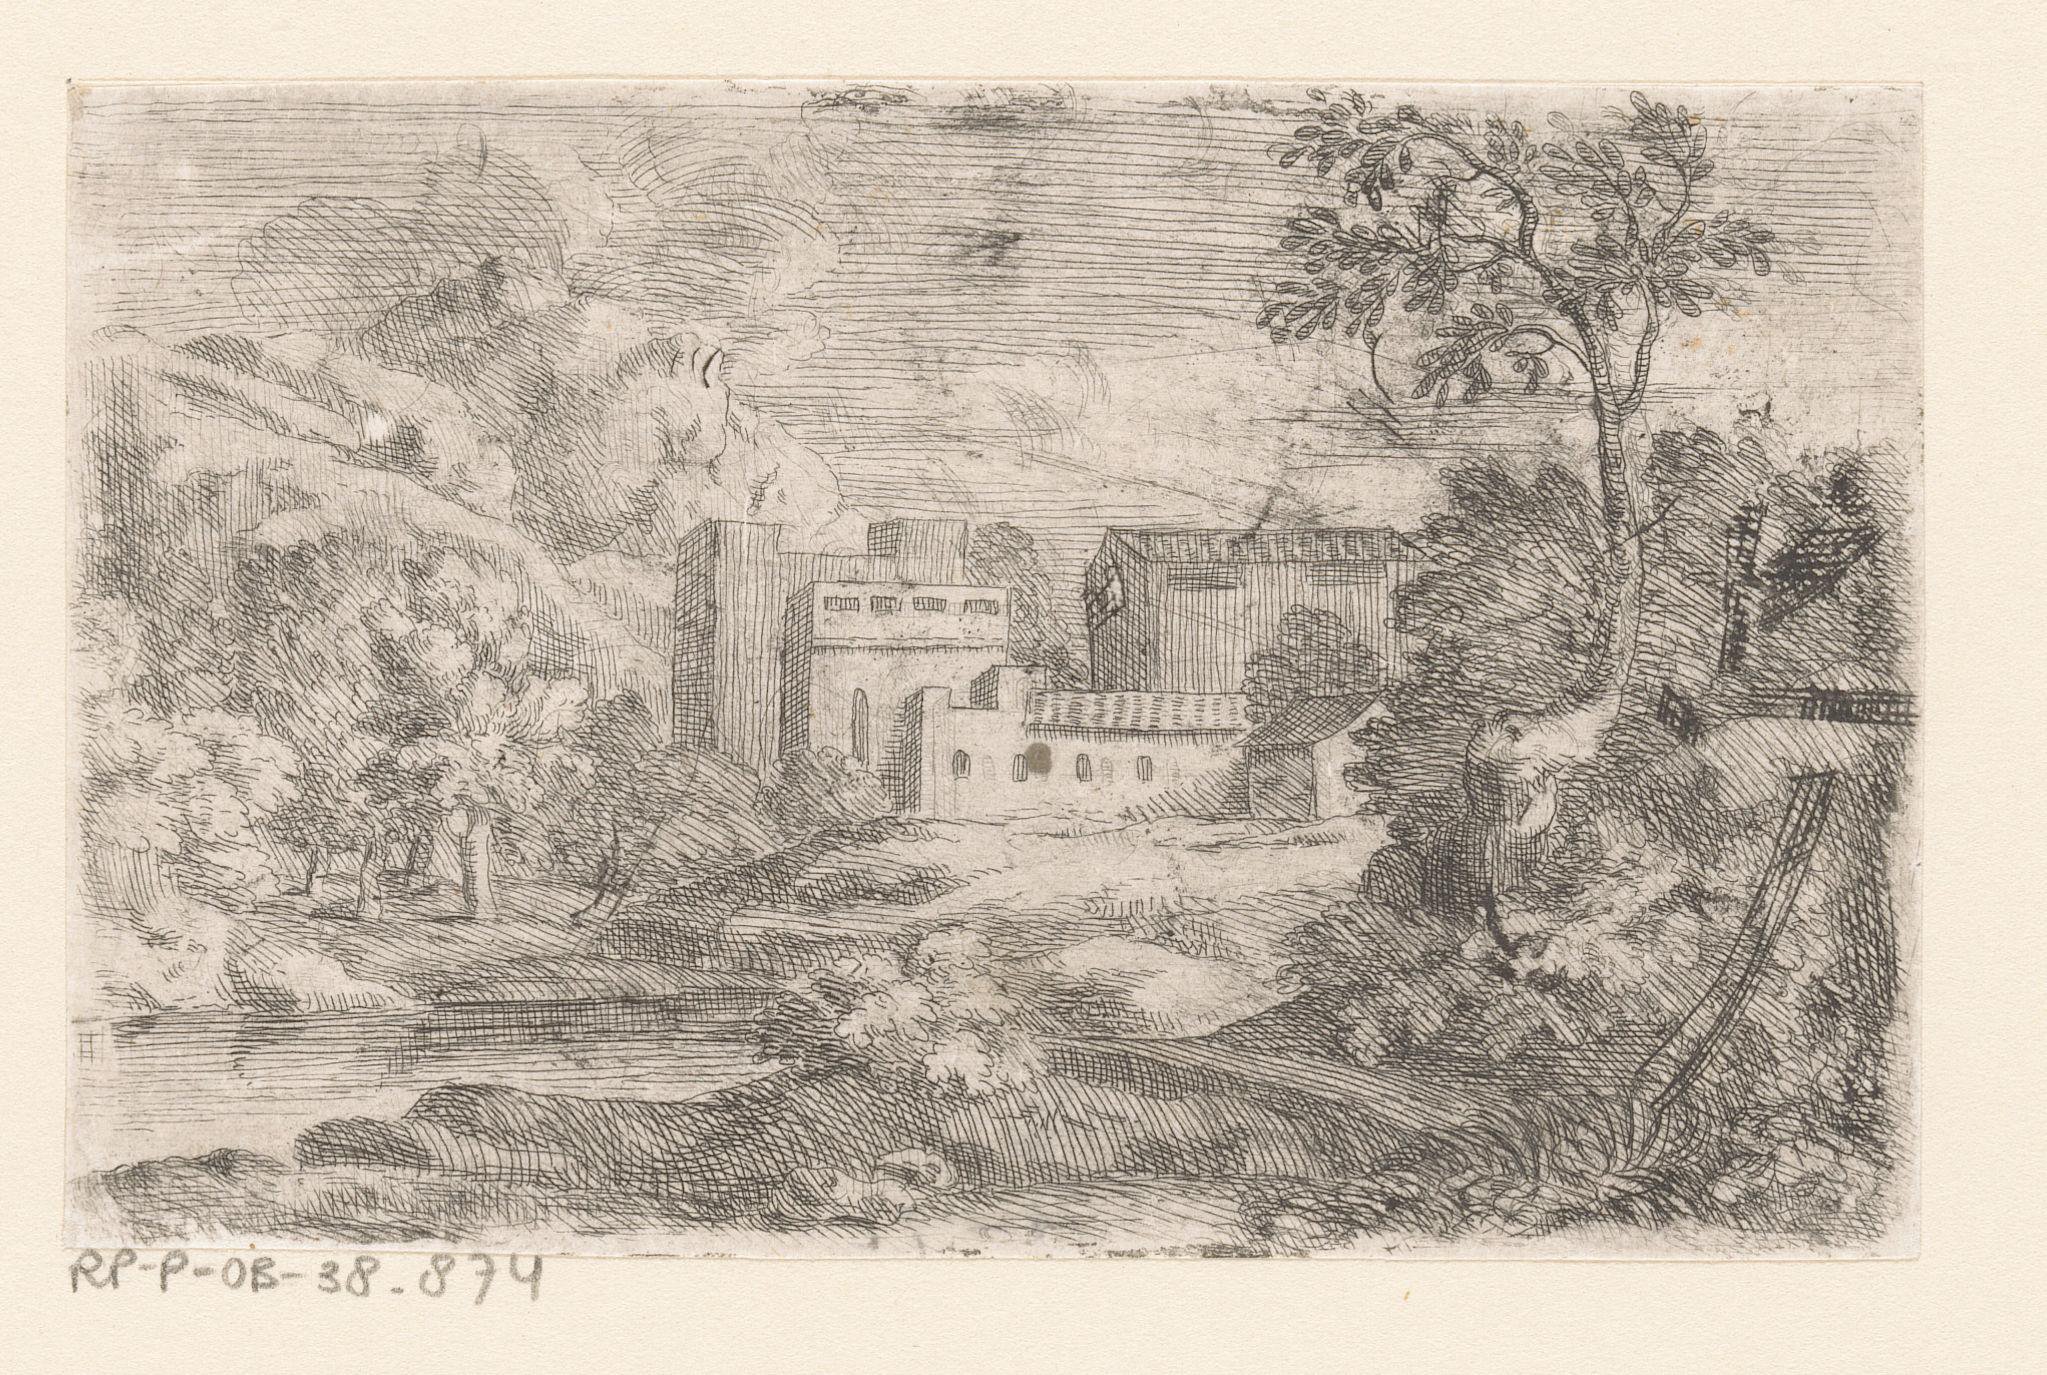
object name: print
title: Heuvellandschap met bebouwing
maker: Anonymous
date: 1600-1699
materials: paper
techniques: etching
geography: italy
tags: landscapes, country-house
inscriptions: collector's mark: Lugt 240